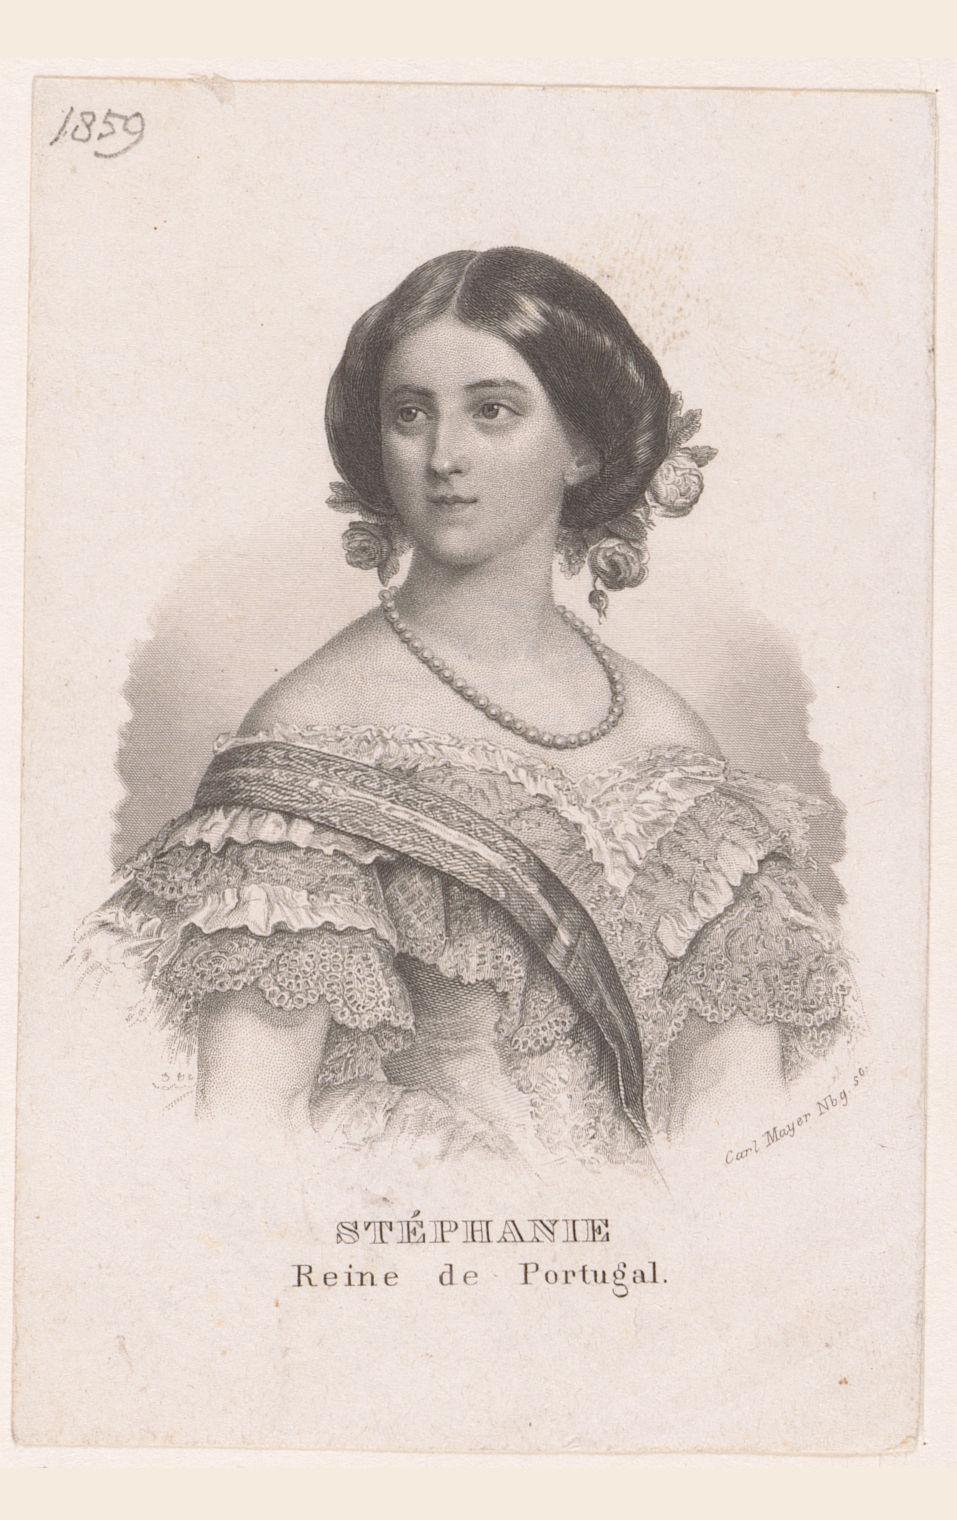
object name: print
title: Portret van Stephanie von Hohenzollern-Sigmaringen, koningin van Portugal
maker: carl mayer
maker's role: print maker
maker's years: 1798-1868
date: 1859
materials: paper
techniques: engraving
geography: nuremberg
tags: historical persons - bb - woman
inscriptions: collector's mark: Lugt 2228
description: Prent afkomstig uit de Almanach de Gotha, 1859.